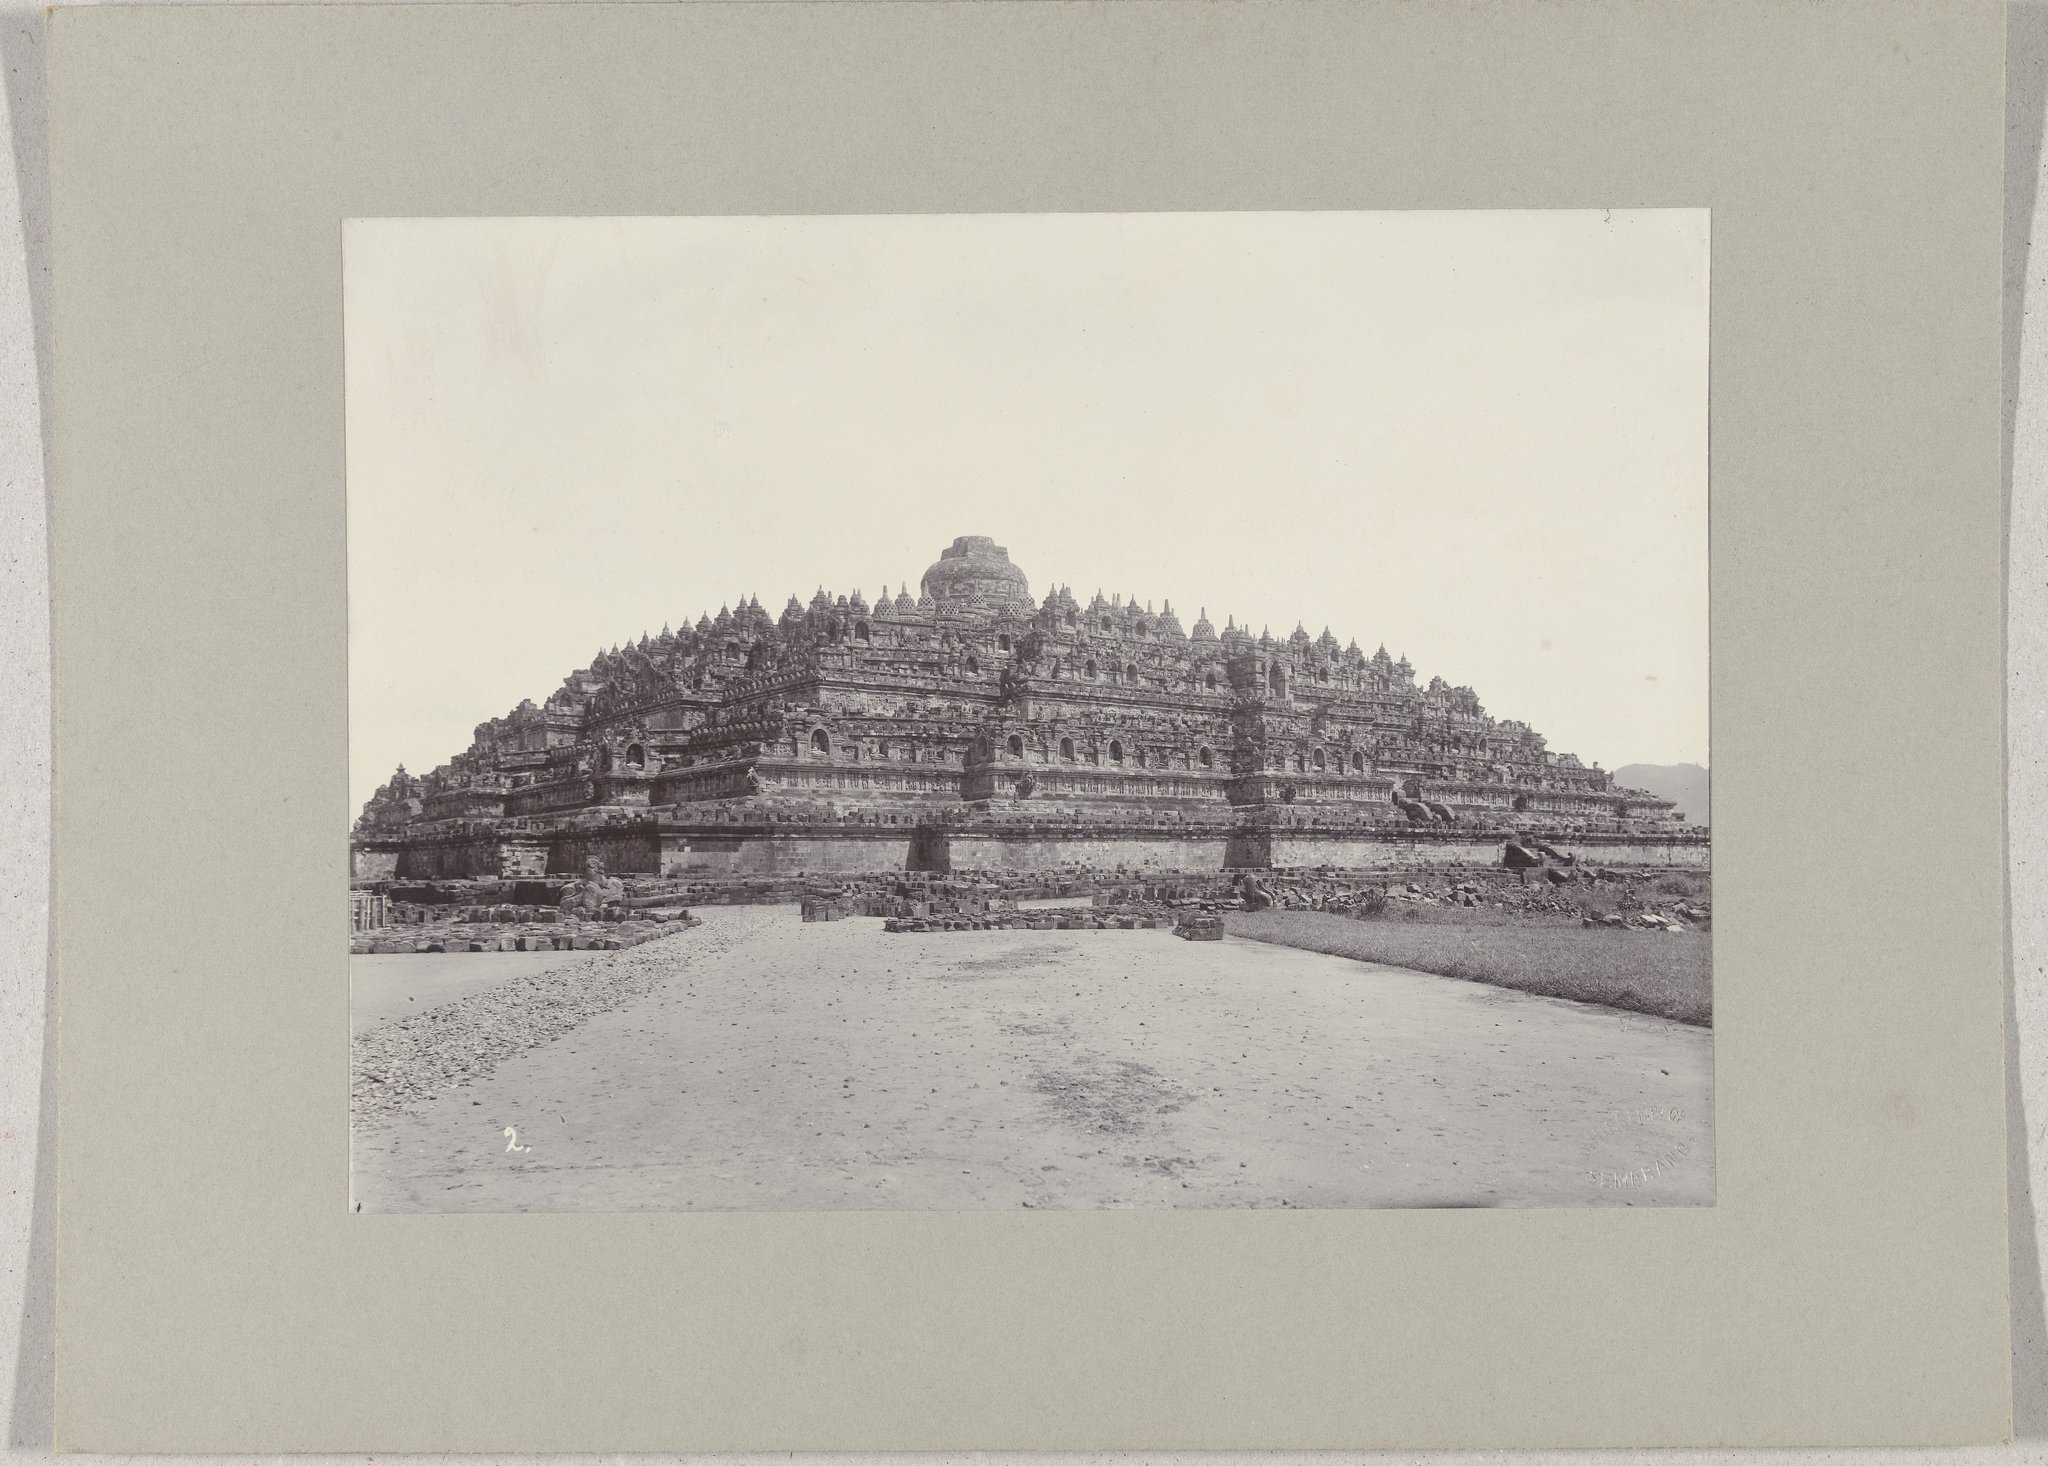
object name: photograph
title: Borobudur (Boroboedoer), nabij Magelang, Nederlands-Indië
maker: otto hisgen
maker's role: fotograaf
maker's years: 1874-1944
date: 1895-1915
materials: cardboard, paper, photographic support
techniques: gelatin silver print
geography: magelang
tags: borobudur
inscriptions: check stamp: ‘O. Hisgen & Co / Semarang’, number: ‘2’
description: Borobudur (Boroboedoer), nabij Magelang, Nederlands-Indië